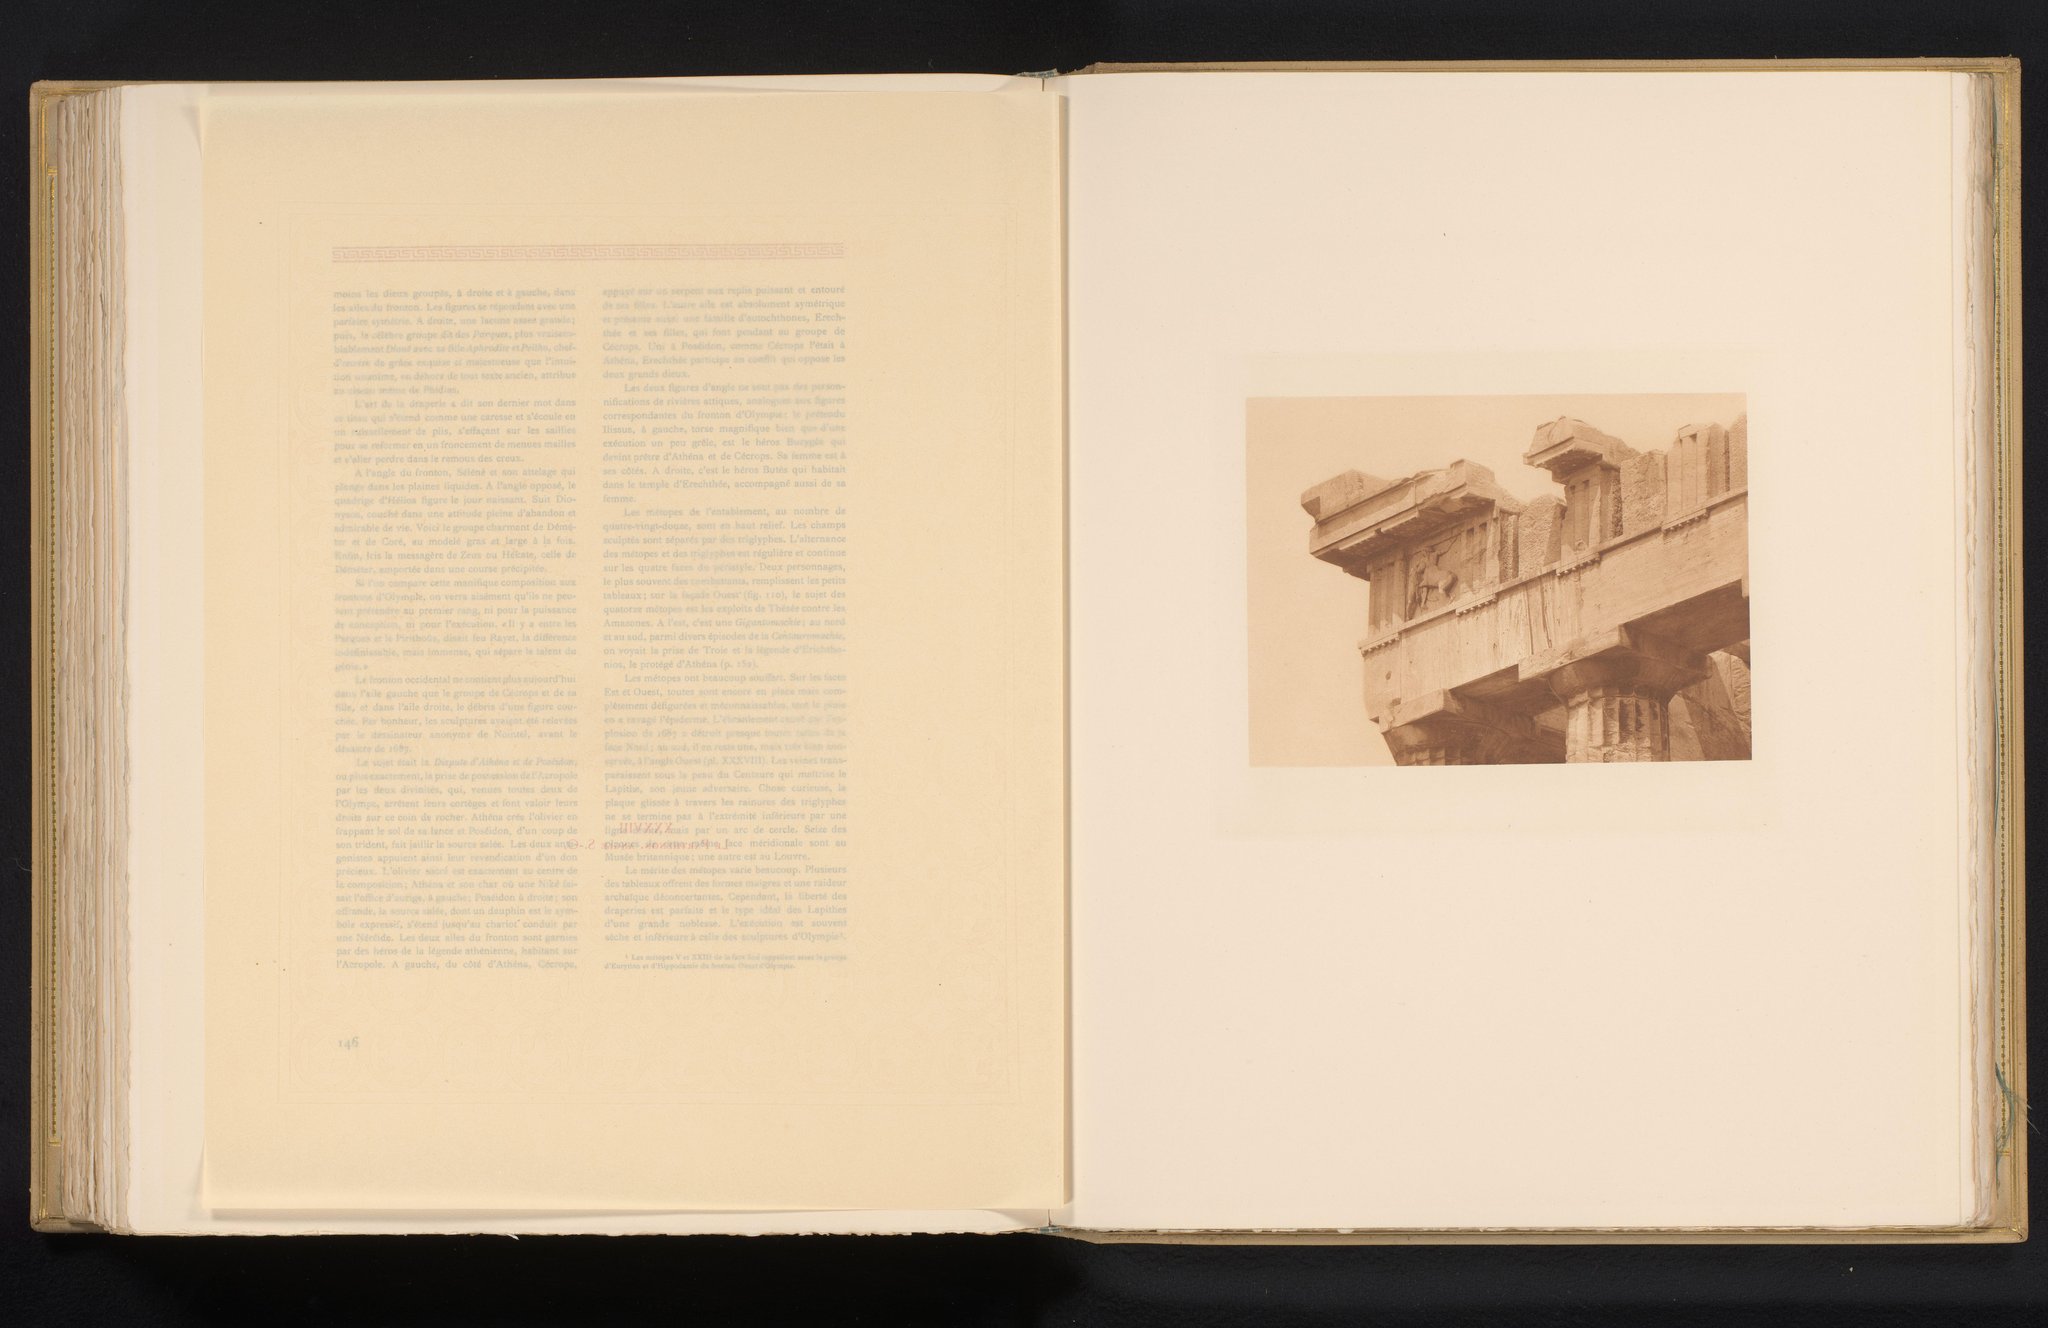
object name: page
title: Fries van het Parthenon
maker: frédéric boissonnas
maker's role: fotograaf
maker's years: 1858-1946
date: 1905-1910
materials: paper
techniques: photoaquatint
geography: acropolis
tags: sculpture